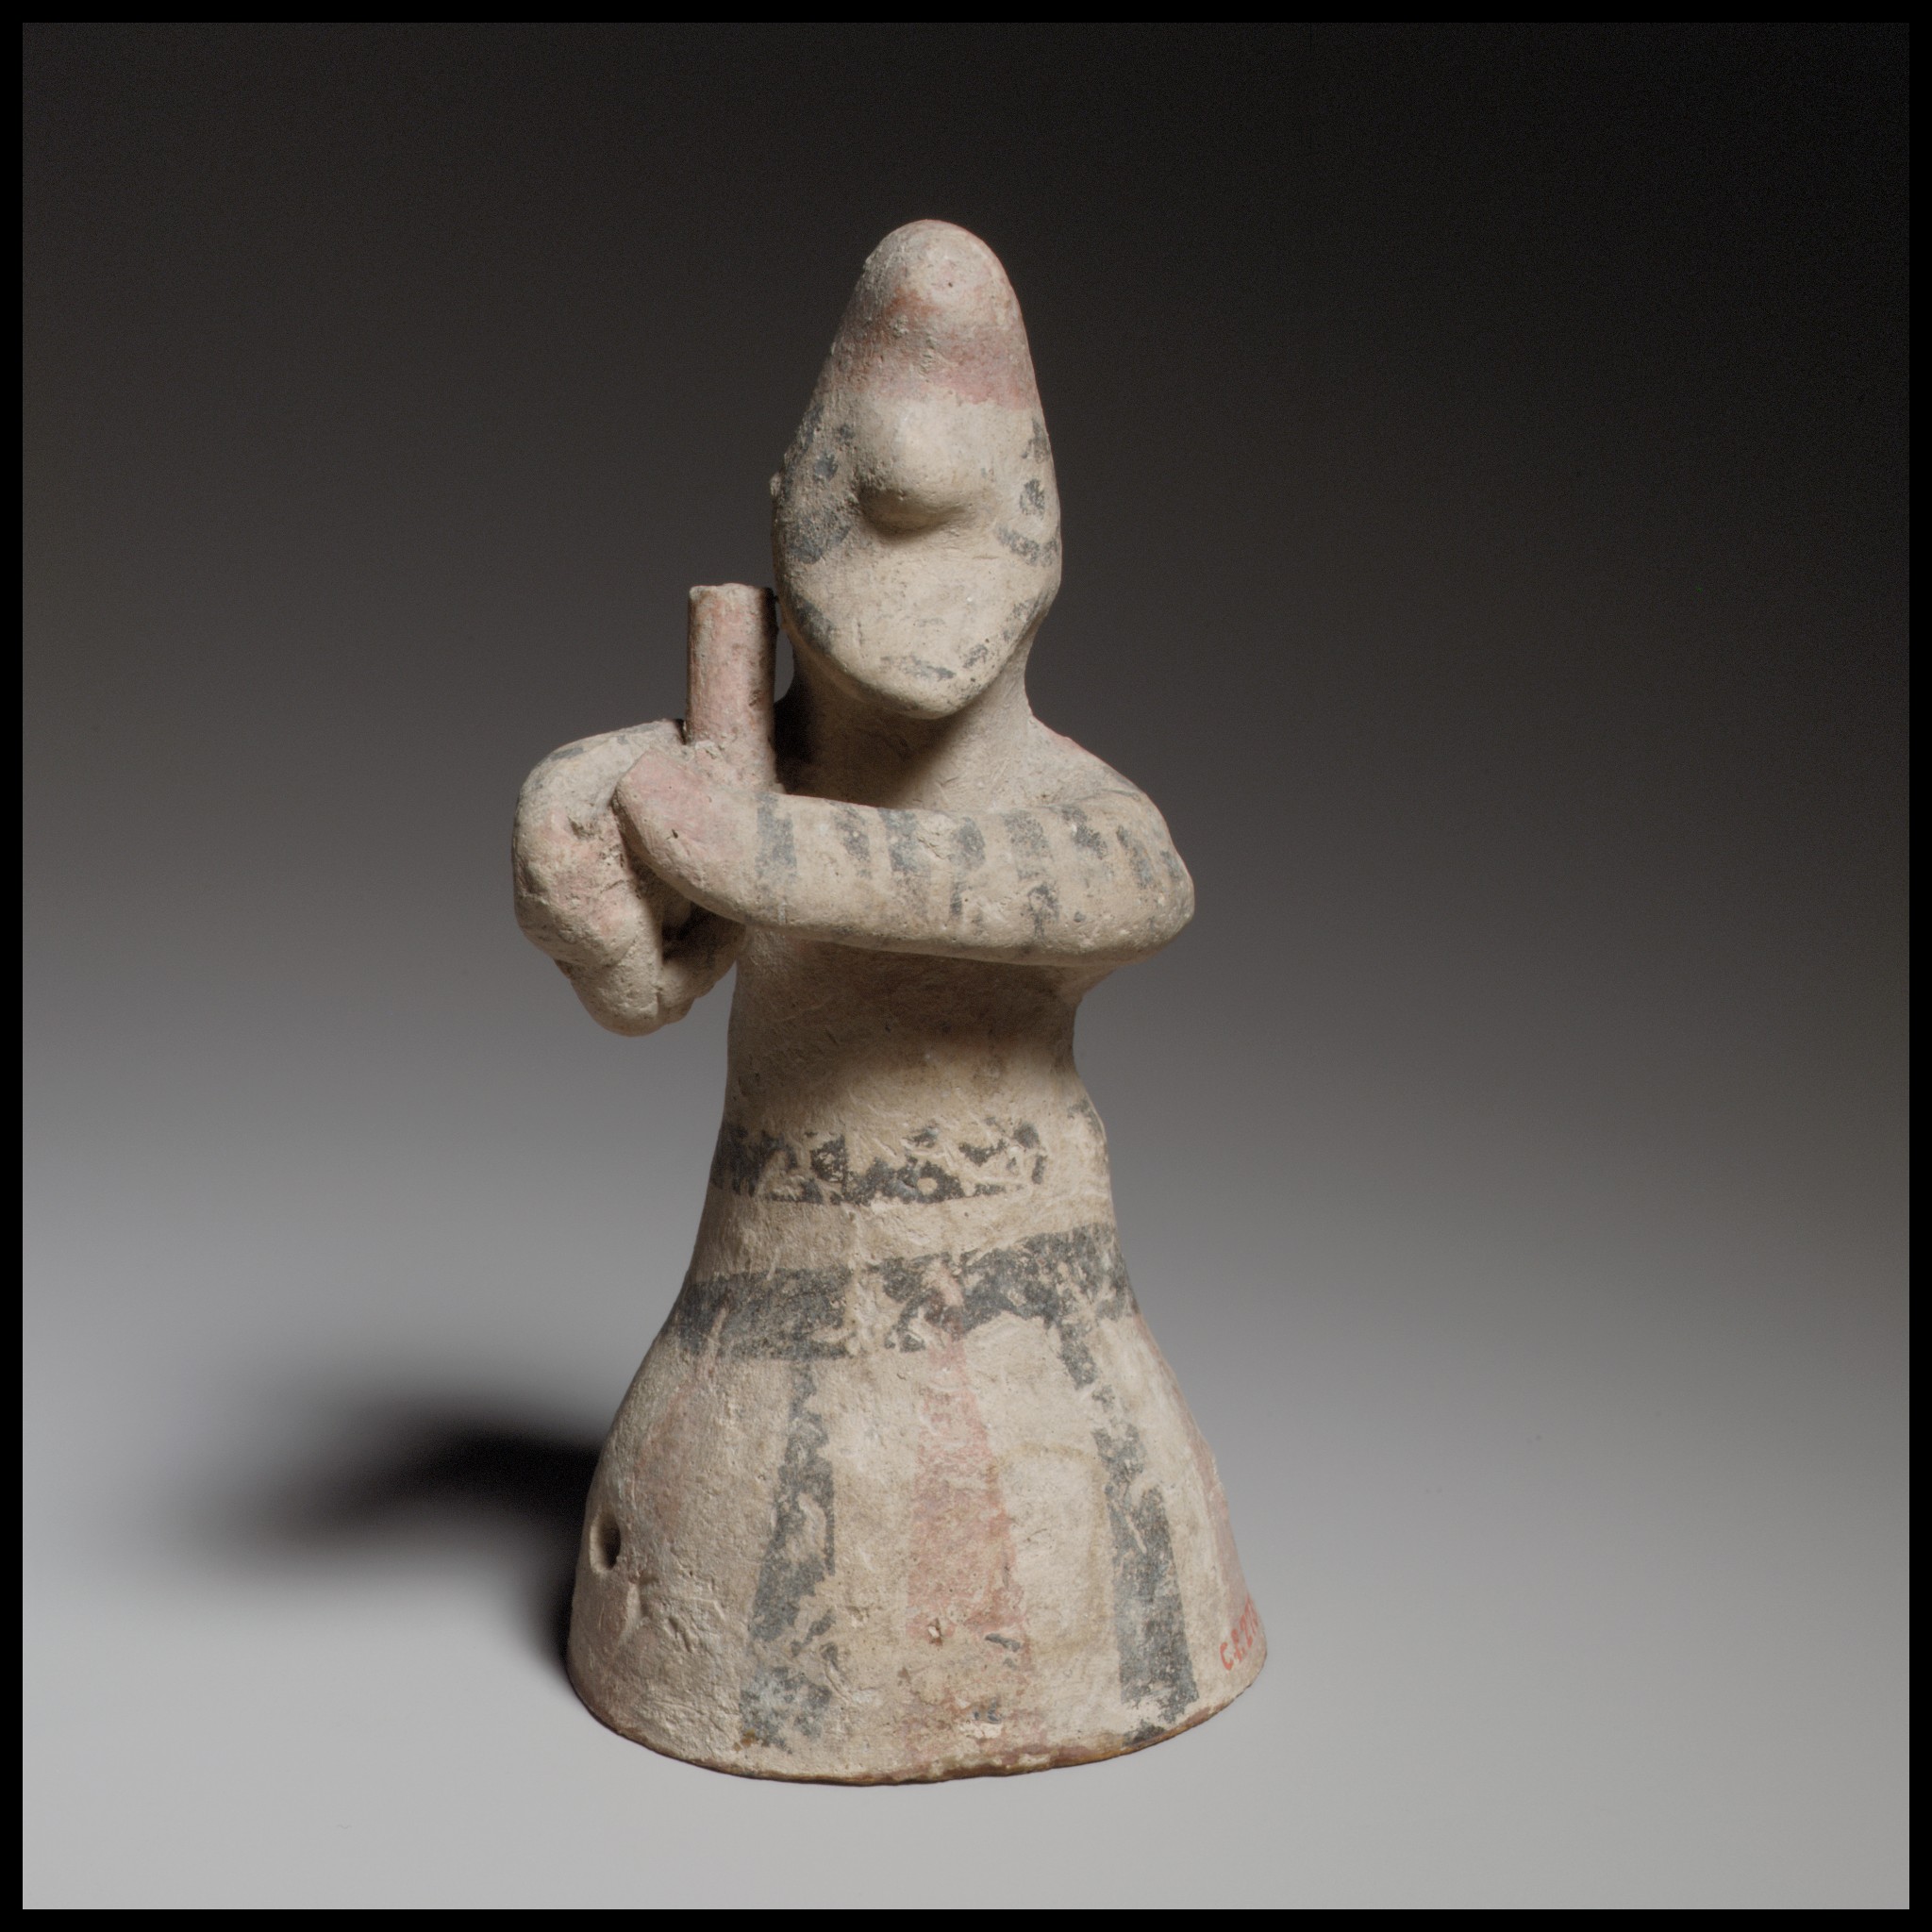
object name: statuette of a man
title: Standing male lyre player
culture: cypriot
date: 750-600 BCE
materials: terracotta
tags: musical instruments,men,musicians